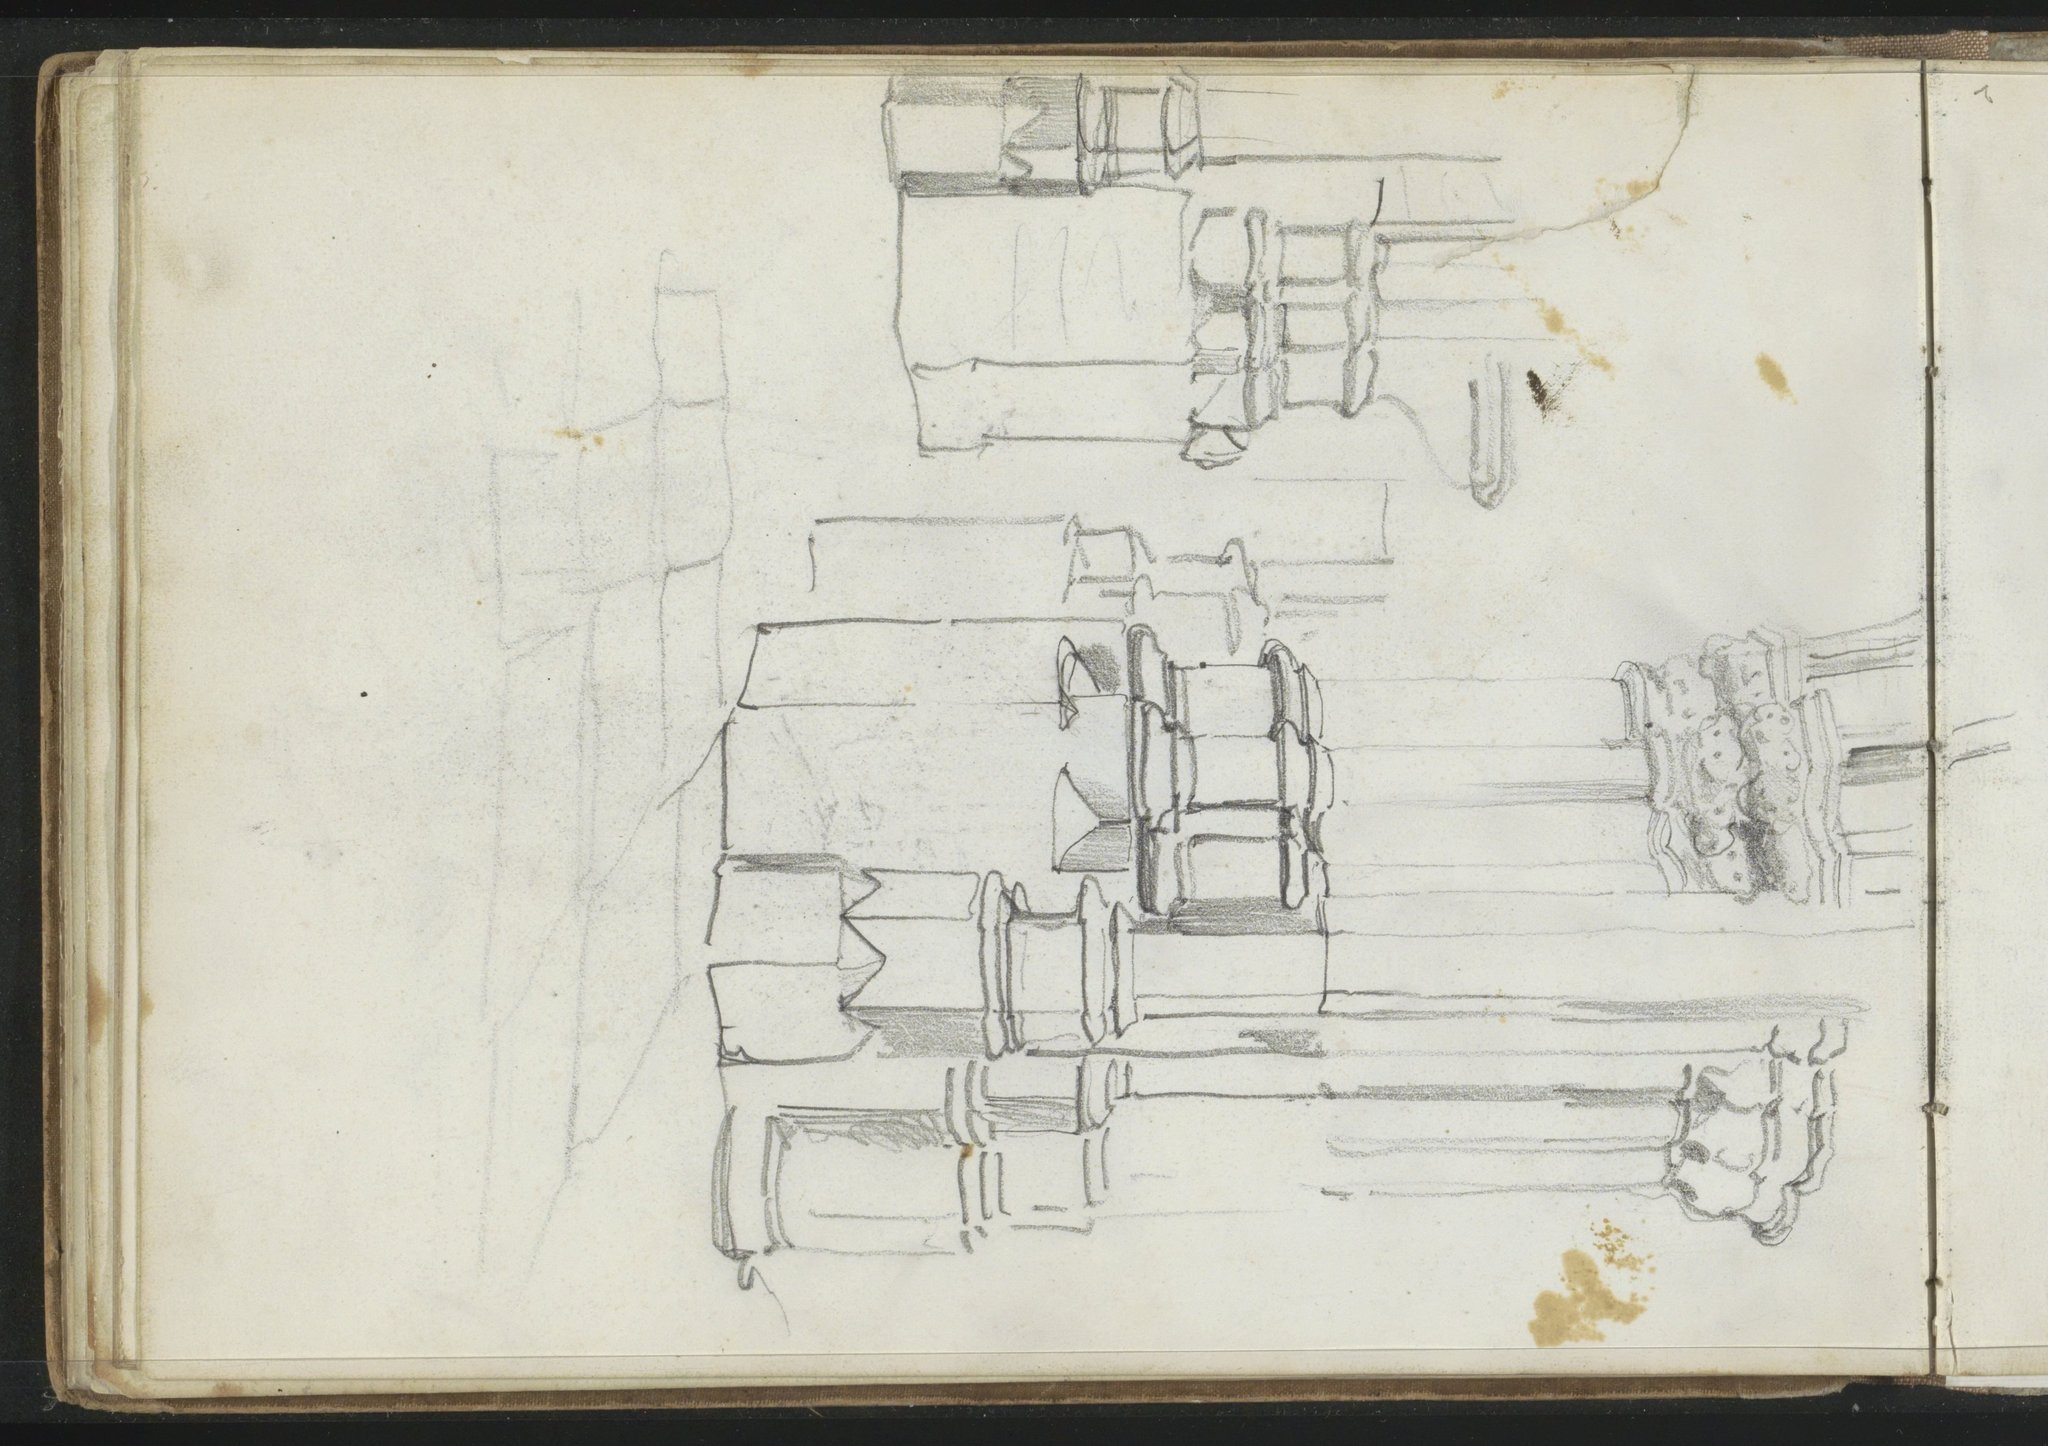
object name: sketchbook leaf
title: Zuilengalerij in een kerk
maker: johannes bosboom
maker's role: draughtsman, painter, print maker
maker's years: 1817-1891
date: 1827-1891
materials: paper, pencil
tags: column, pillar ~ architecture, interior of church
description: Blad 31 verso uit een schetsboek met 41 pagina's.